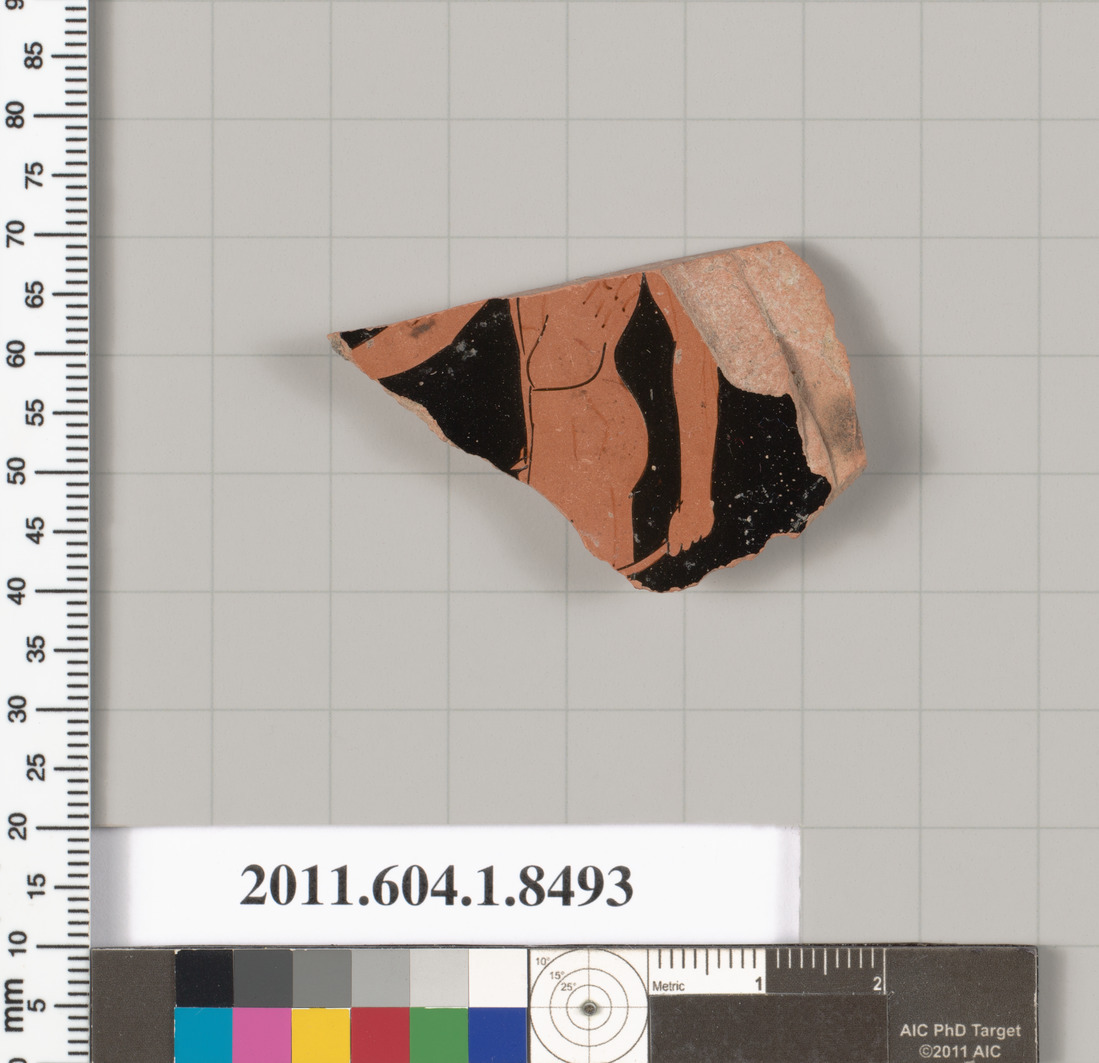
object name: kylix fragment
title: Terracotta fragment of a stemless kylix (drinking cup)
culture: greek, attic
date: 475-451 BCE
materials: terracotta